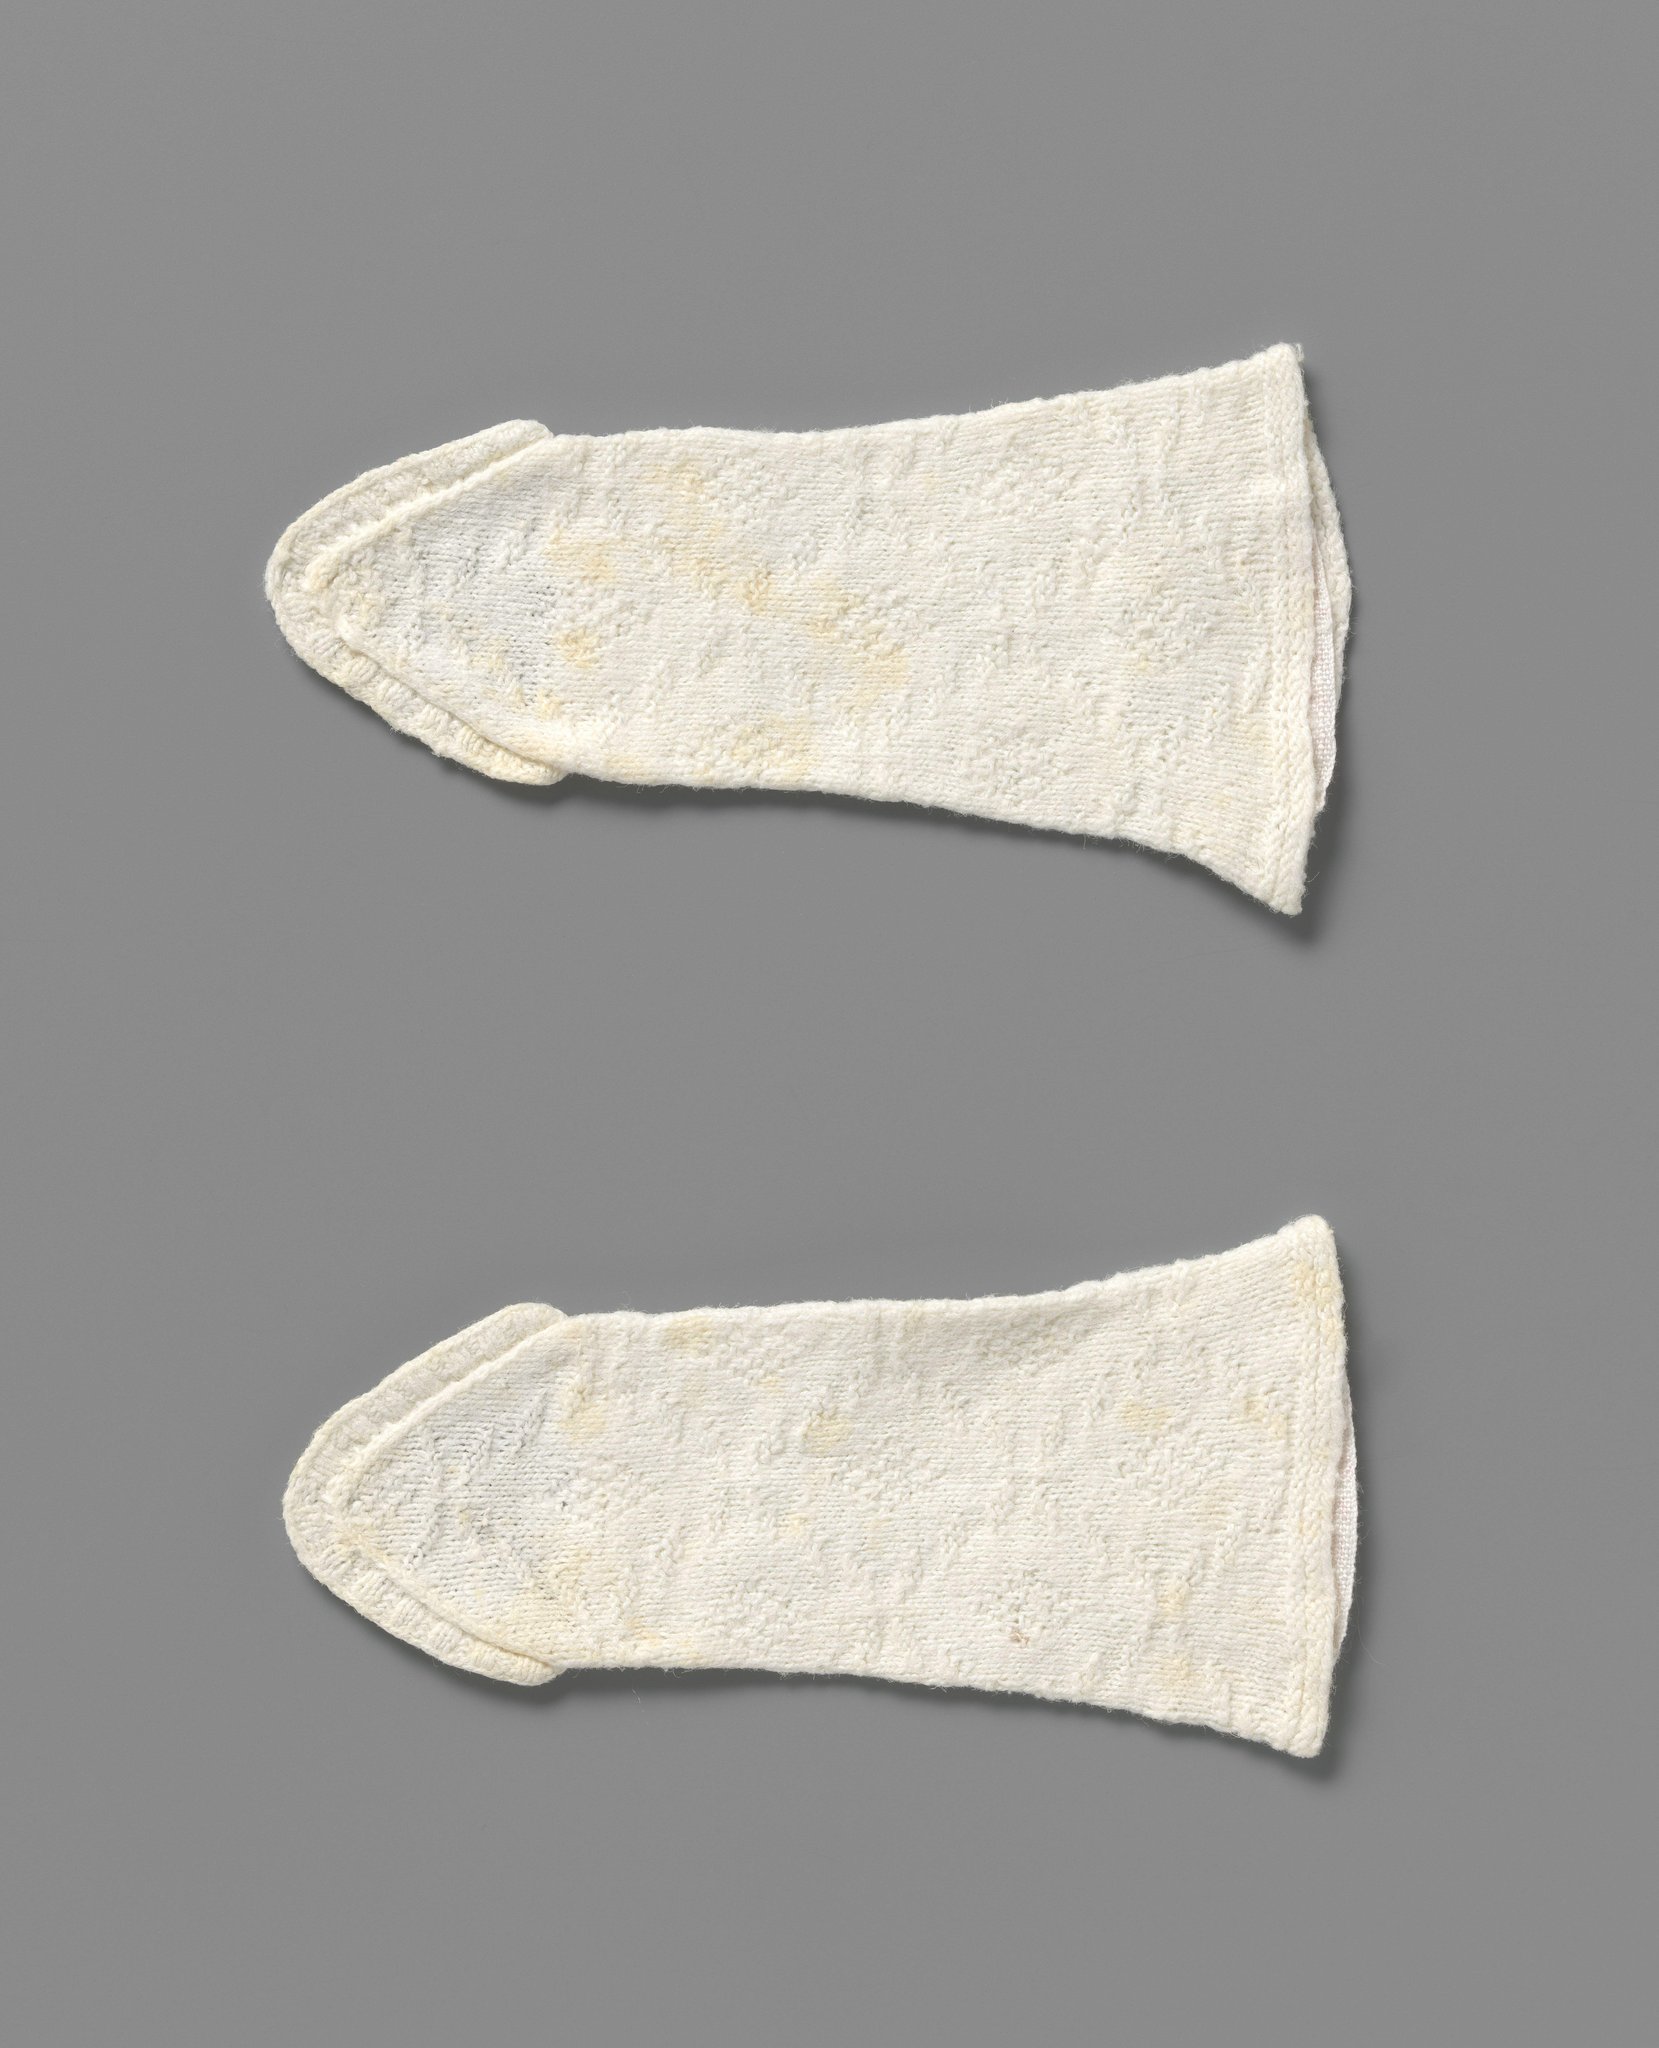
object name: childrenswear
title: Mitaine van witte gebreide katoen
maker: Anonymous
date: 1790-1820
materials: cotton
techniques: knitting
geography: zaanstreek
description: Mitaine van witte gebreide katoen, gebreid in een ruitpatroon met bloemen, voor baby of klein kind